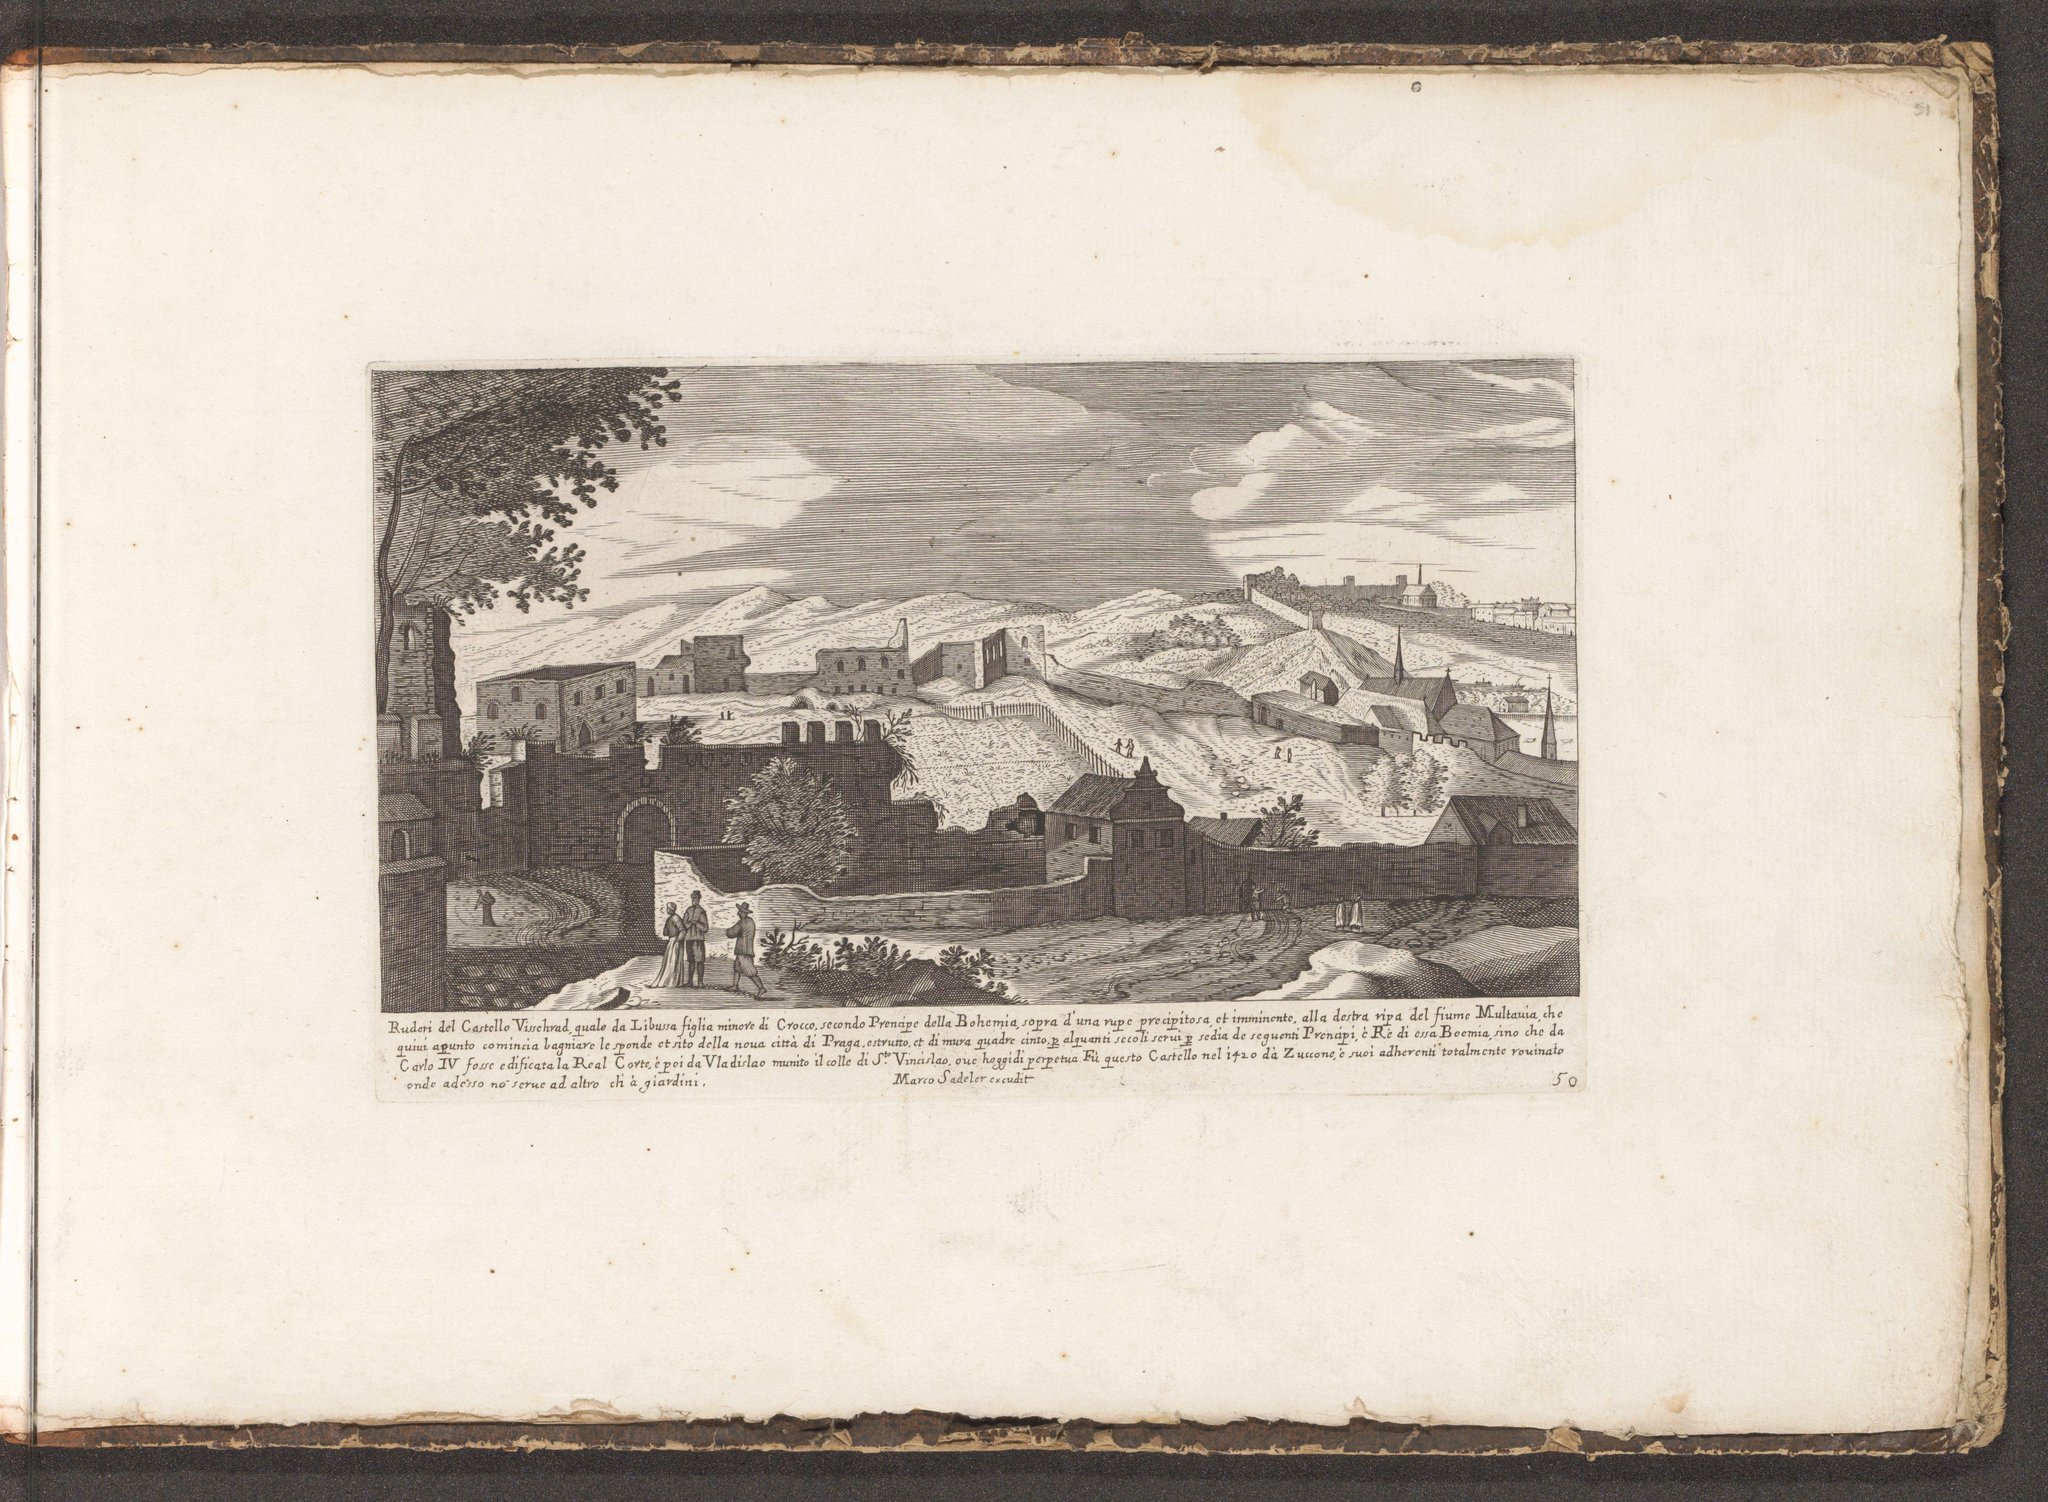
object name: print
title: Vyšehrad in Praag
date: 1680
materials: paper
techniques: engraving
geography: rome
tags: prague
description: Het kasteel Vyšehrad in Praag. In de ondermarge vier regels tekst in het Italiaans. De prent maakt deel uit van een album.